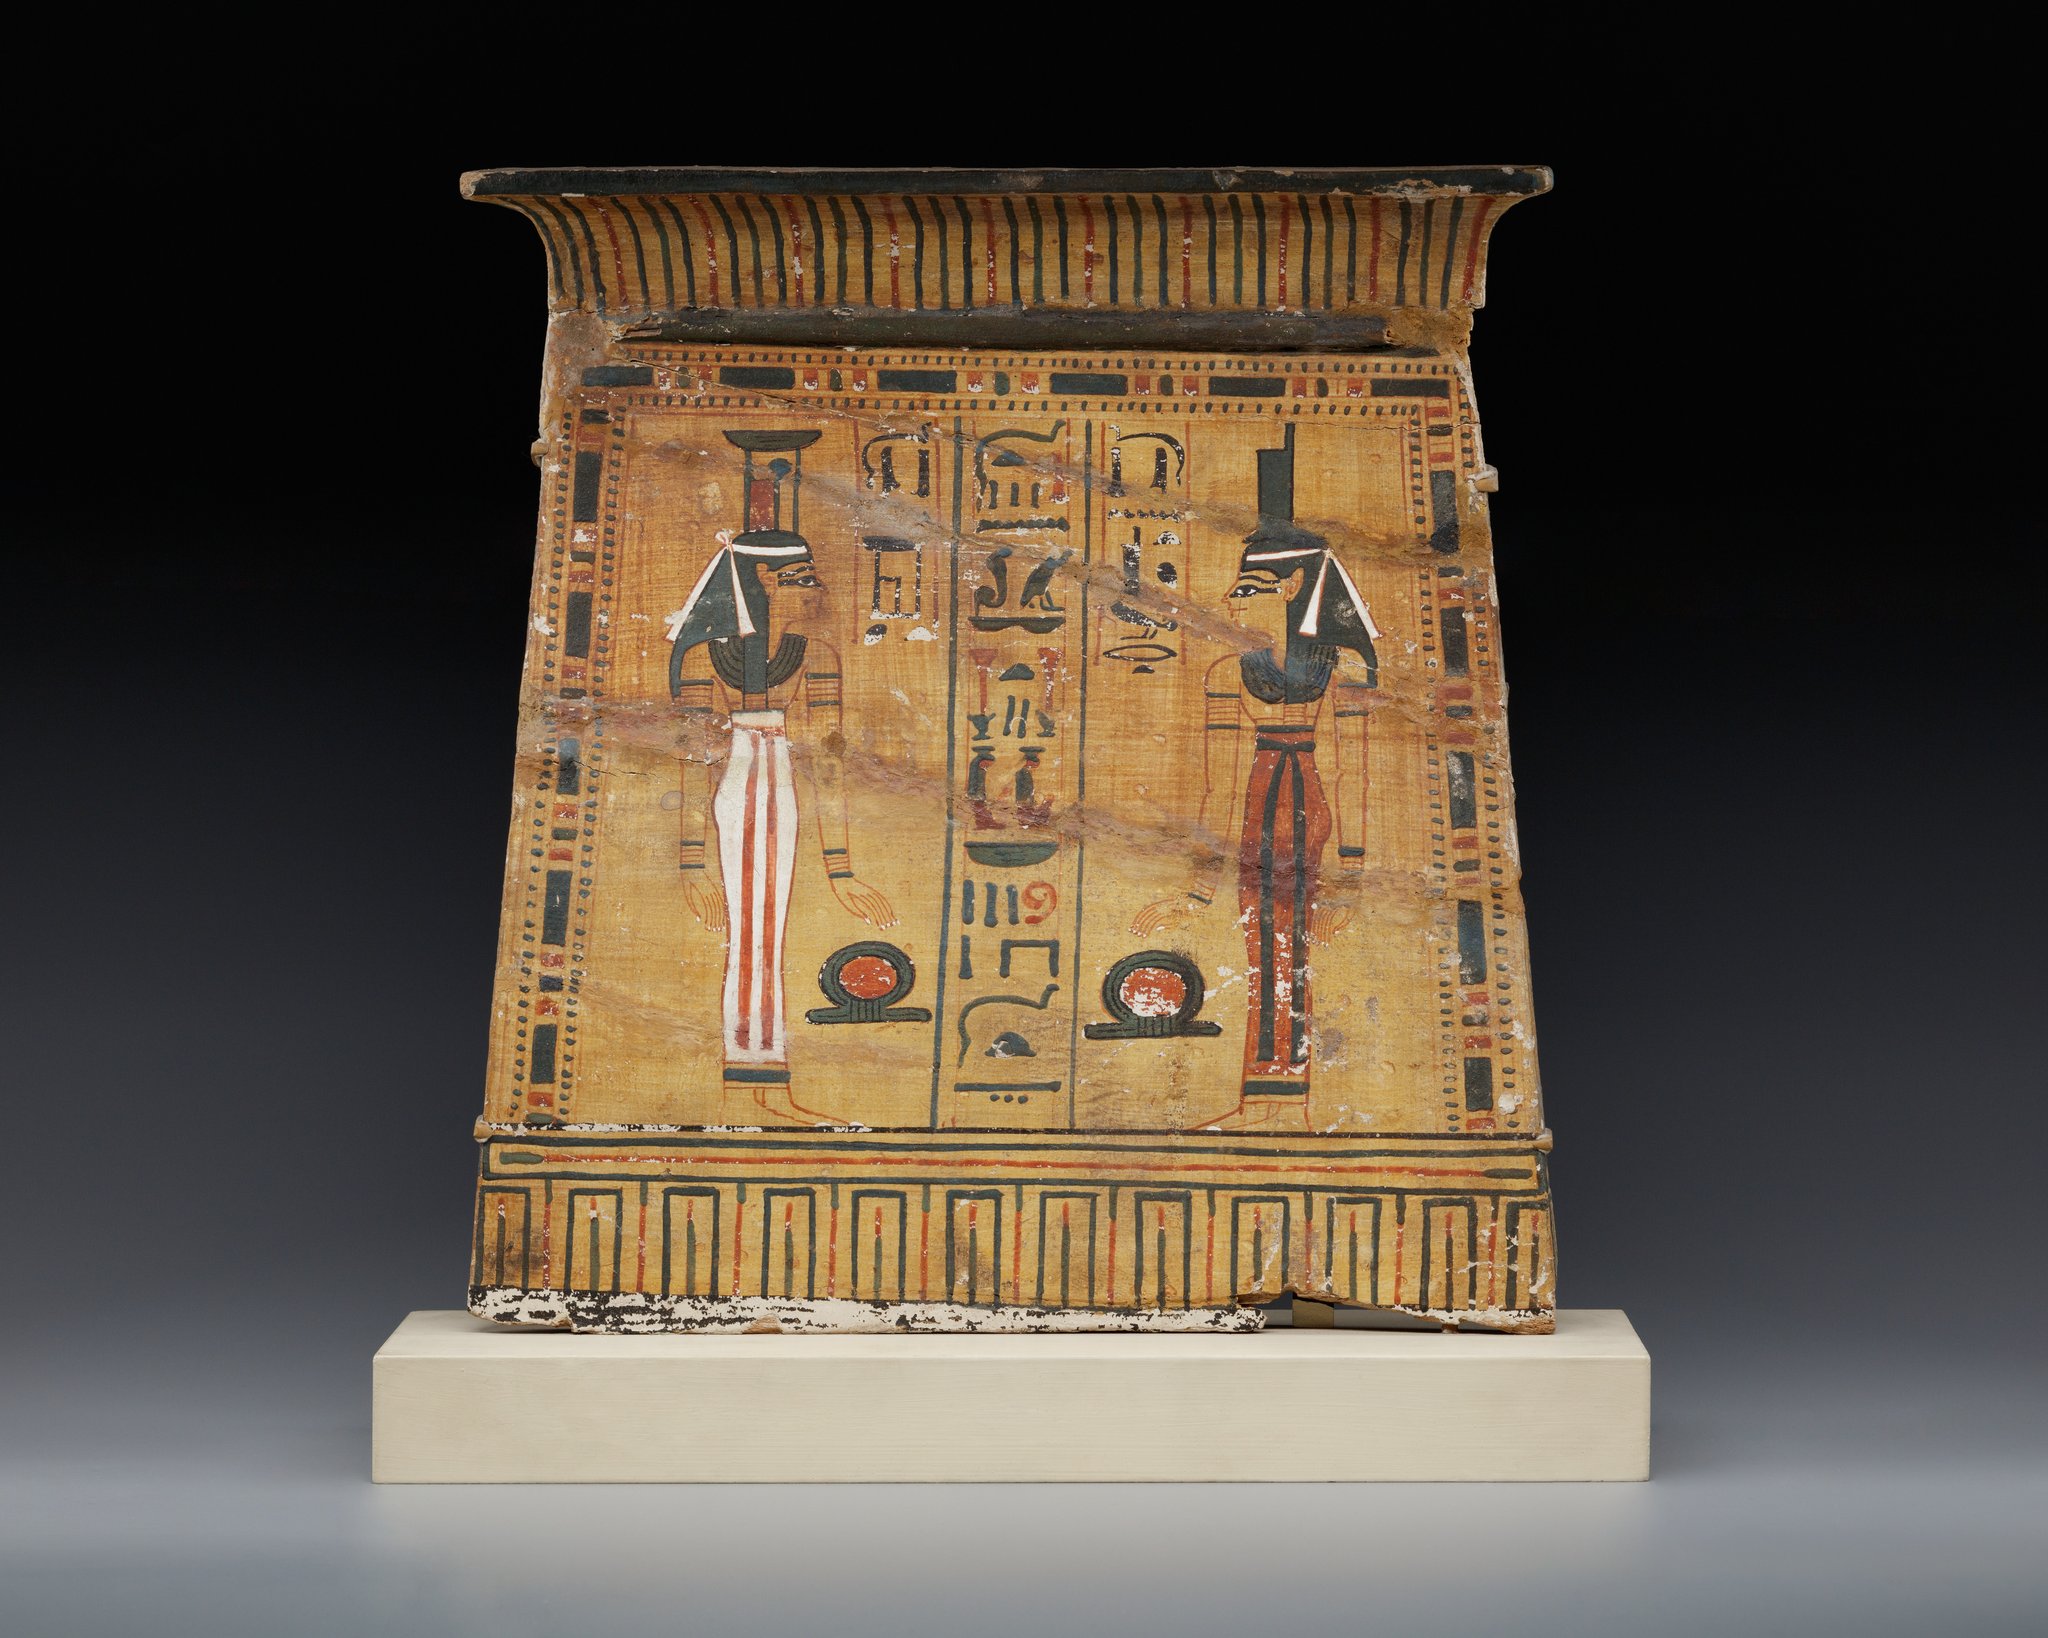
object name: stela, isi, nephthys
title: Painted Panel with Isis and Nephthys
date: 1295-1070 BCE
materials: paint, wood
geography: egypt